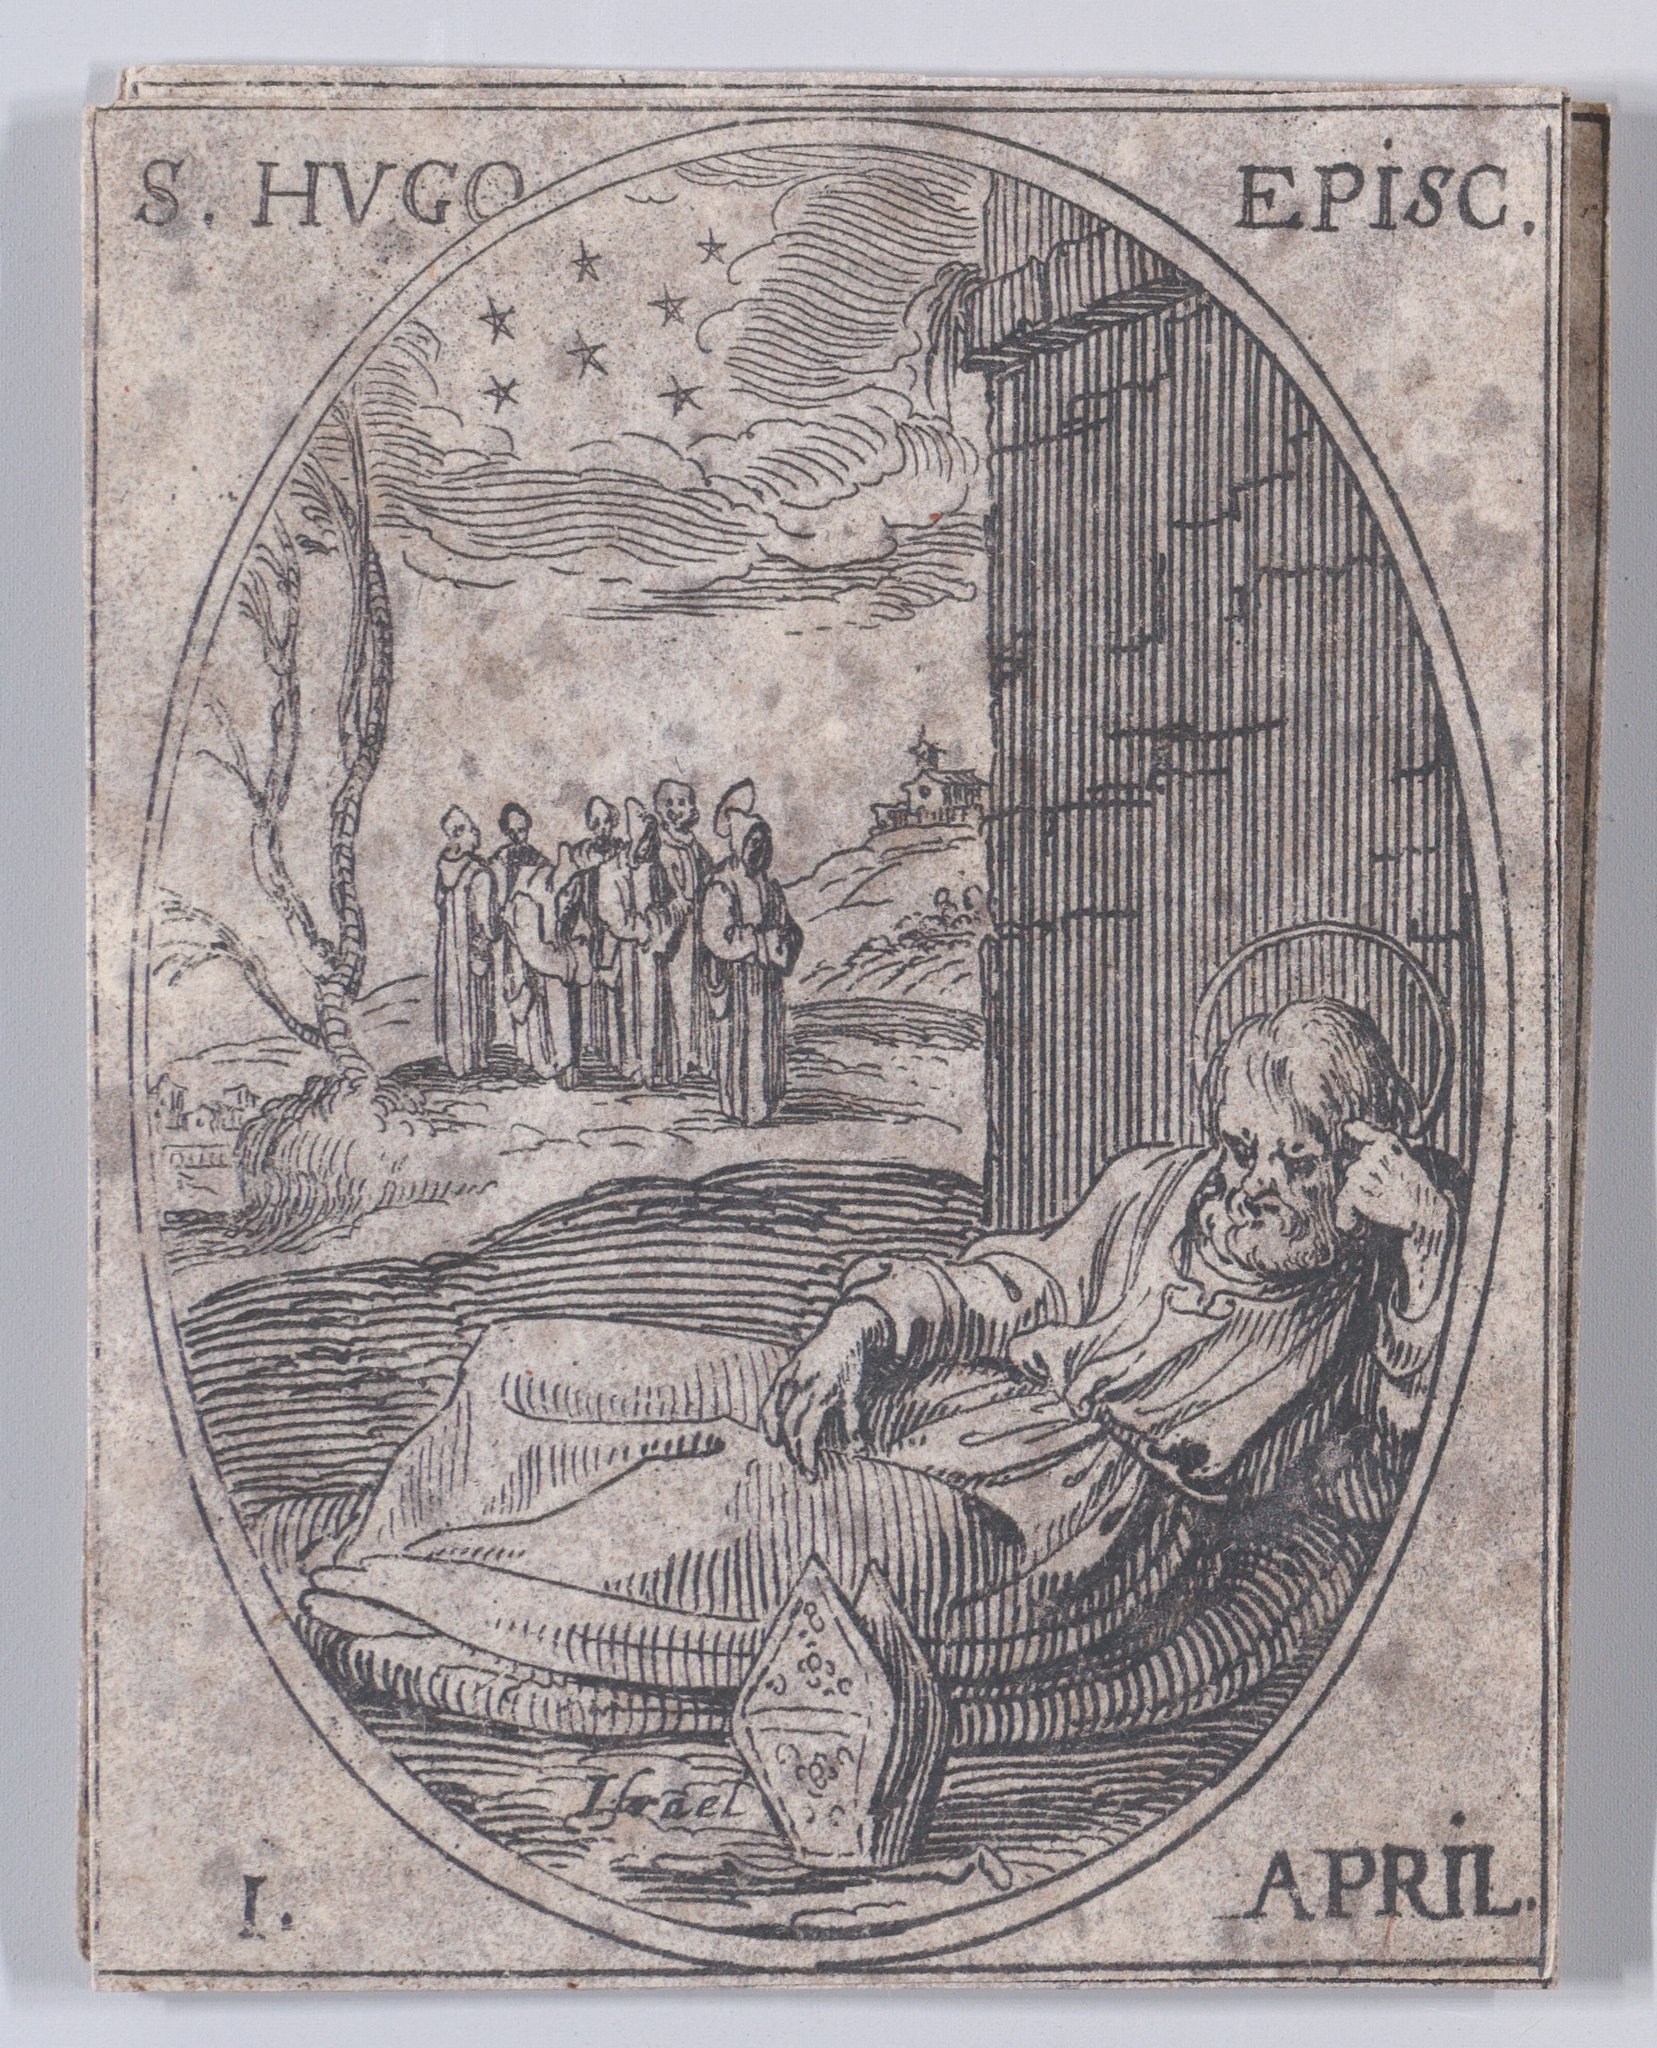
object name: print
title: S. Hugues, évêque (St. Hugh of Grenoble, Bishop), April 1st, from "Les Images De Tous Les Saincts et Saintes de L'Année" (Images of All of the Saints and Religious Events of the Year)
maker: jacques callot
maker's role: artist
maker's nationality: french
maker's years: 1592-1635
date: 1636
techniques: etching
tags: men,saints